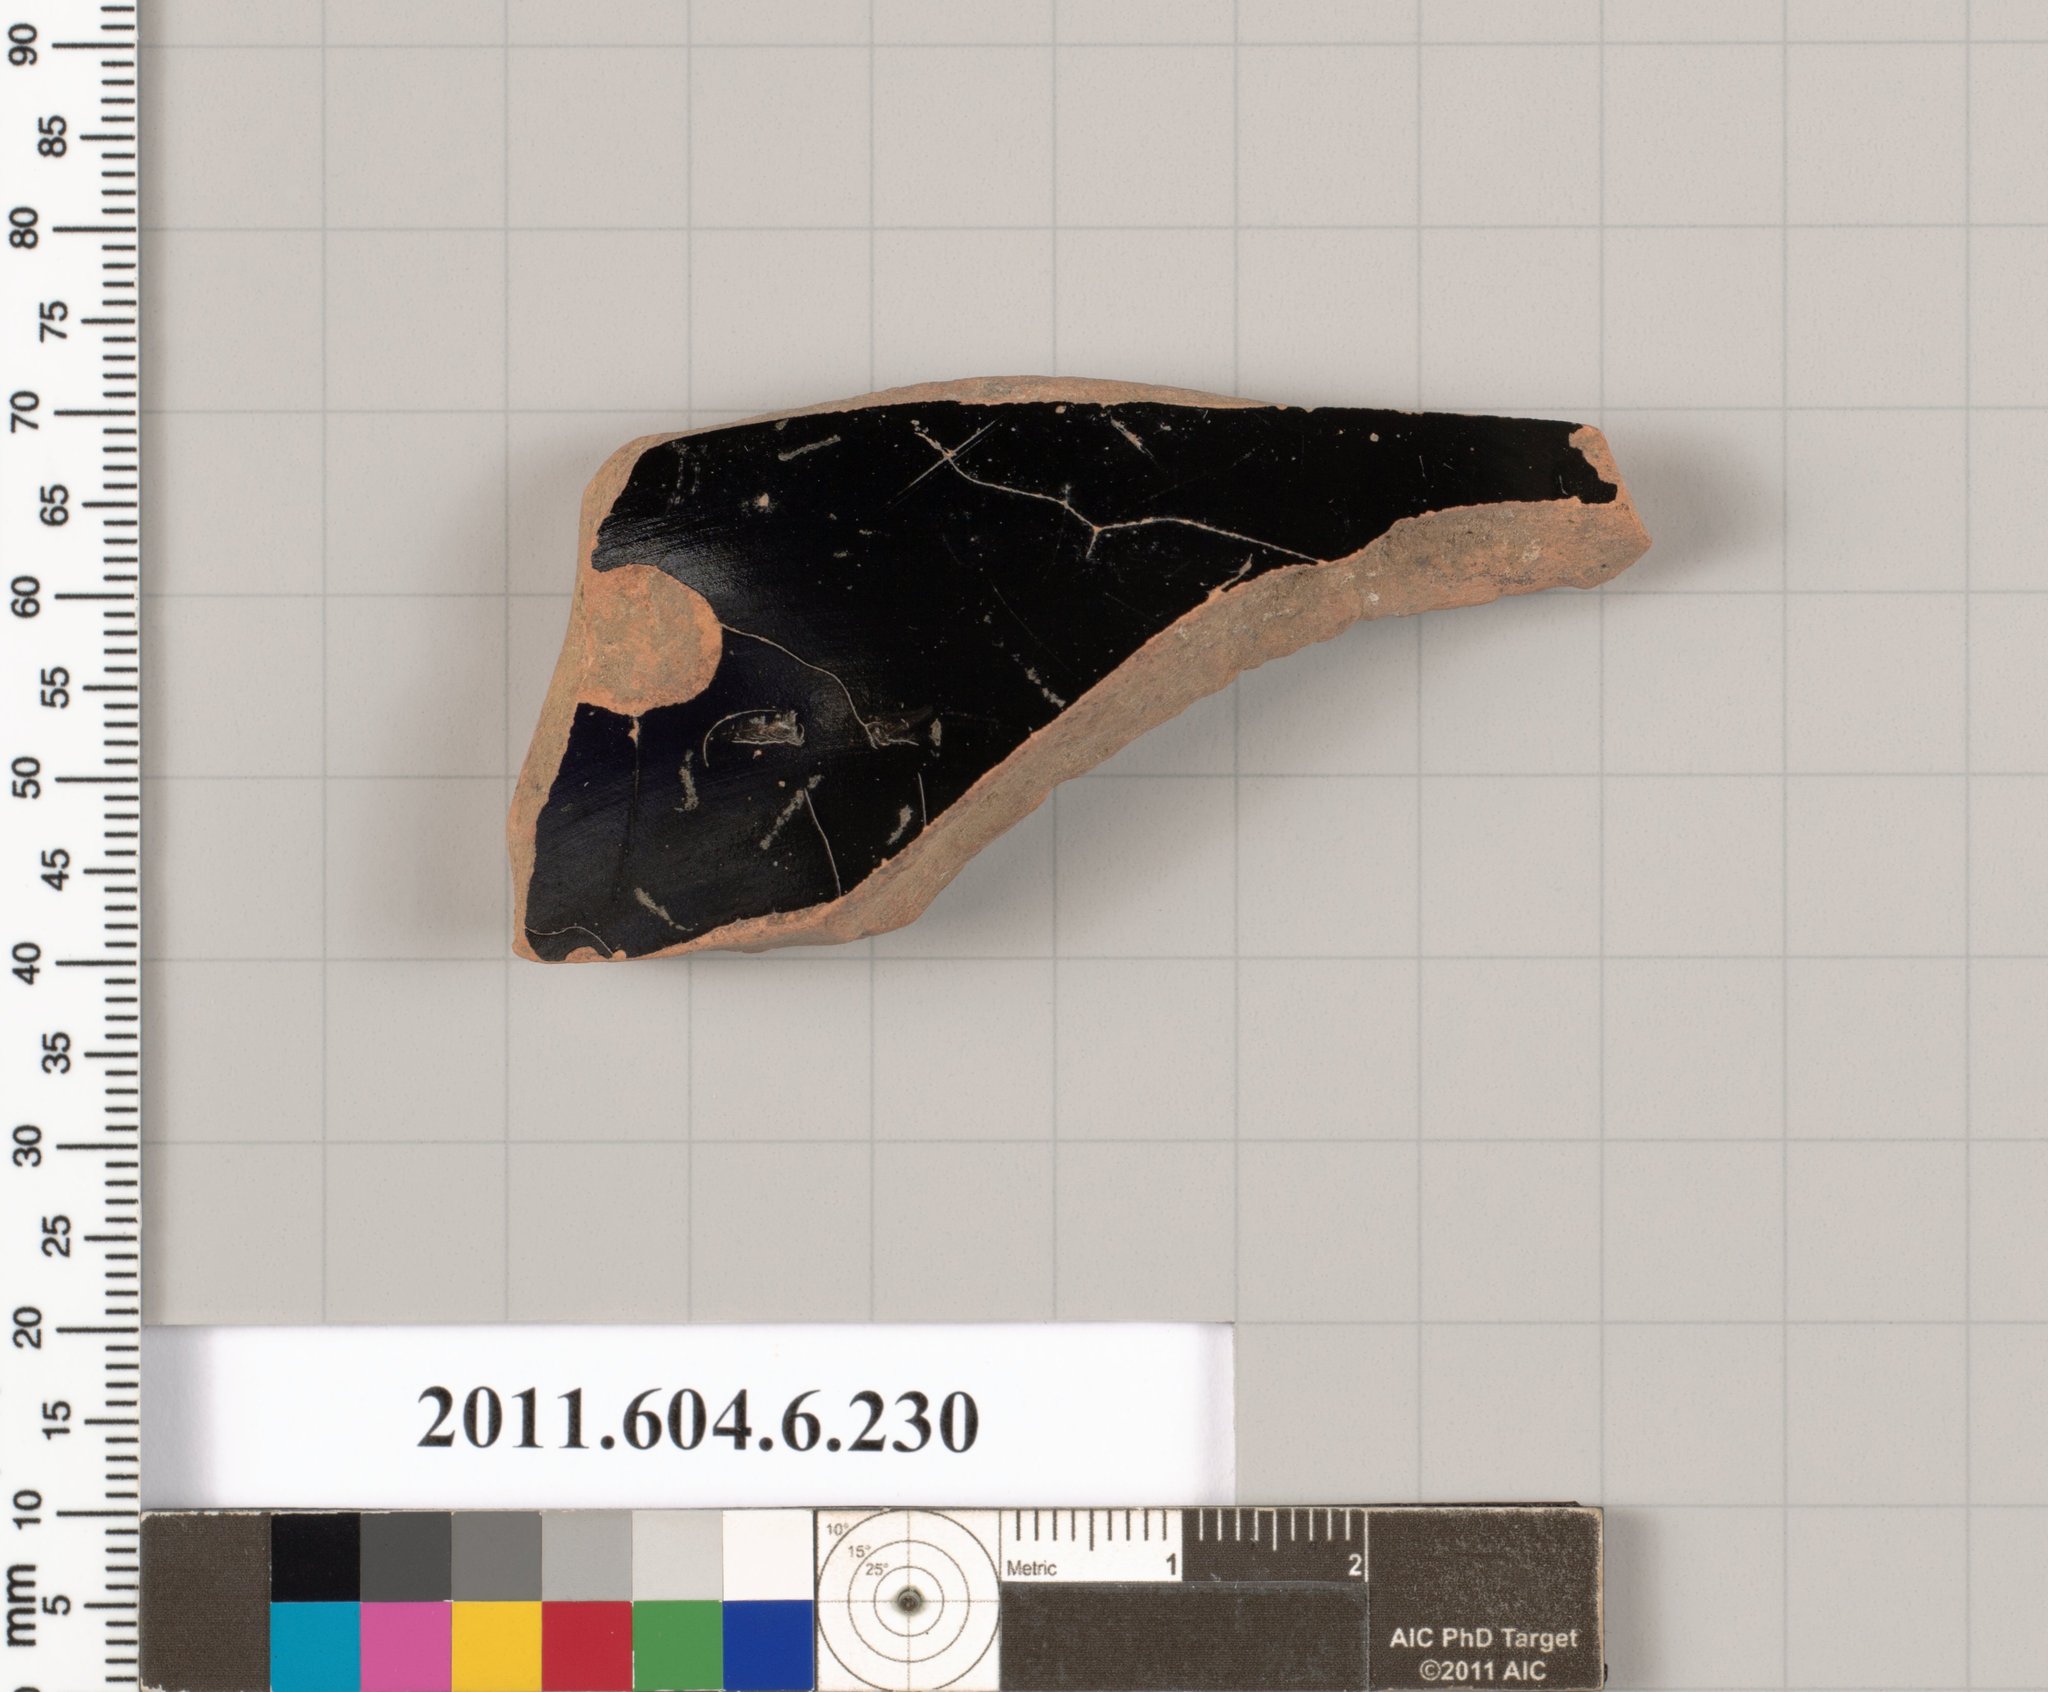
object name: pyxis fragment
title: Terracotta fragment of a pyxis (box) ?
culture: greek, attic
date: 500-401 BCE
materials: terracotta